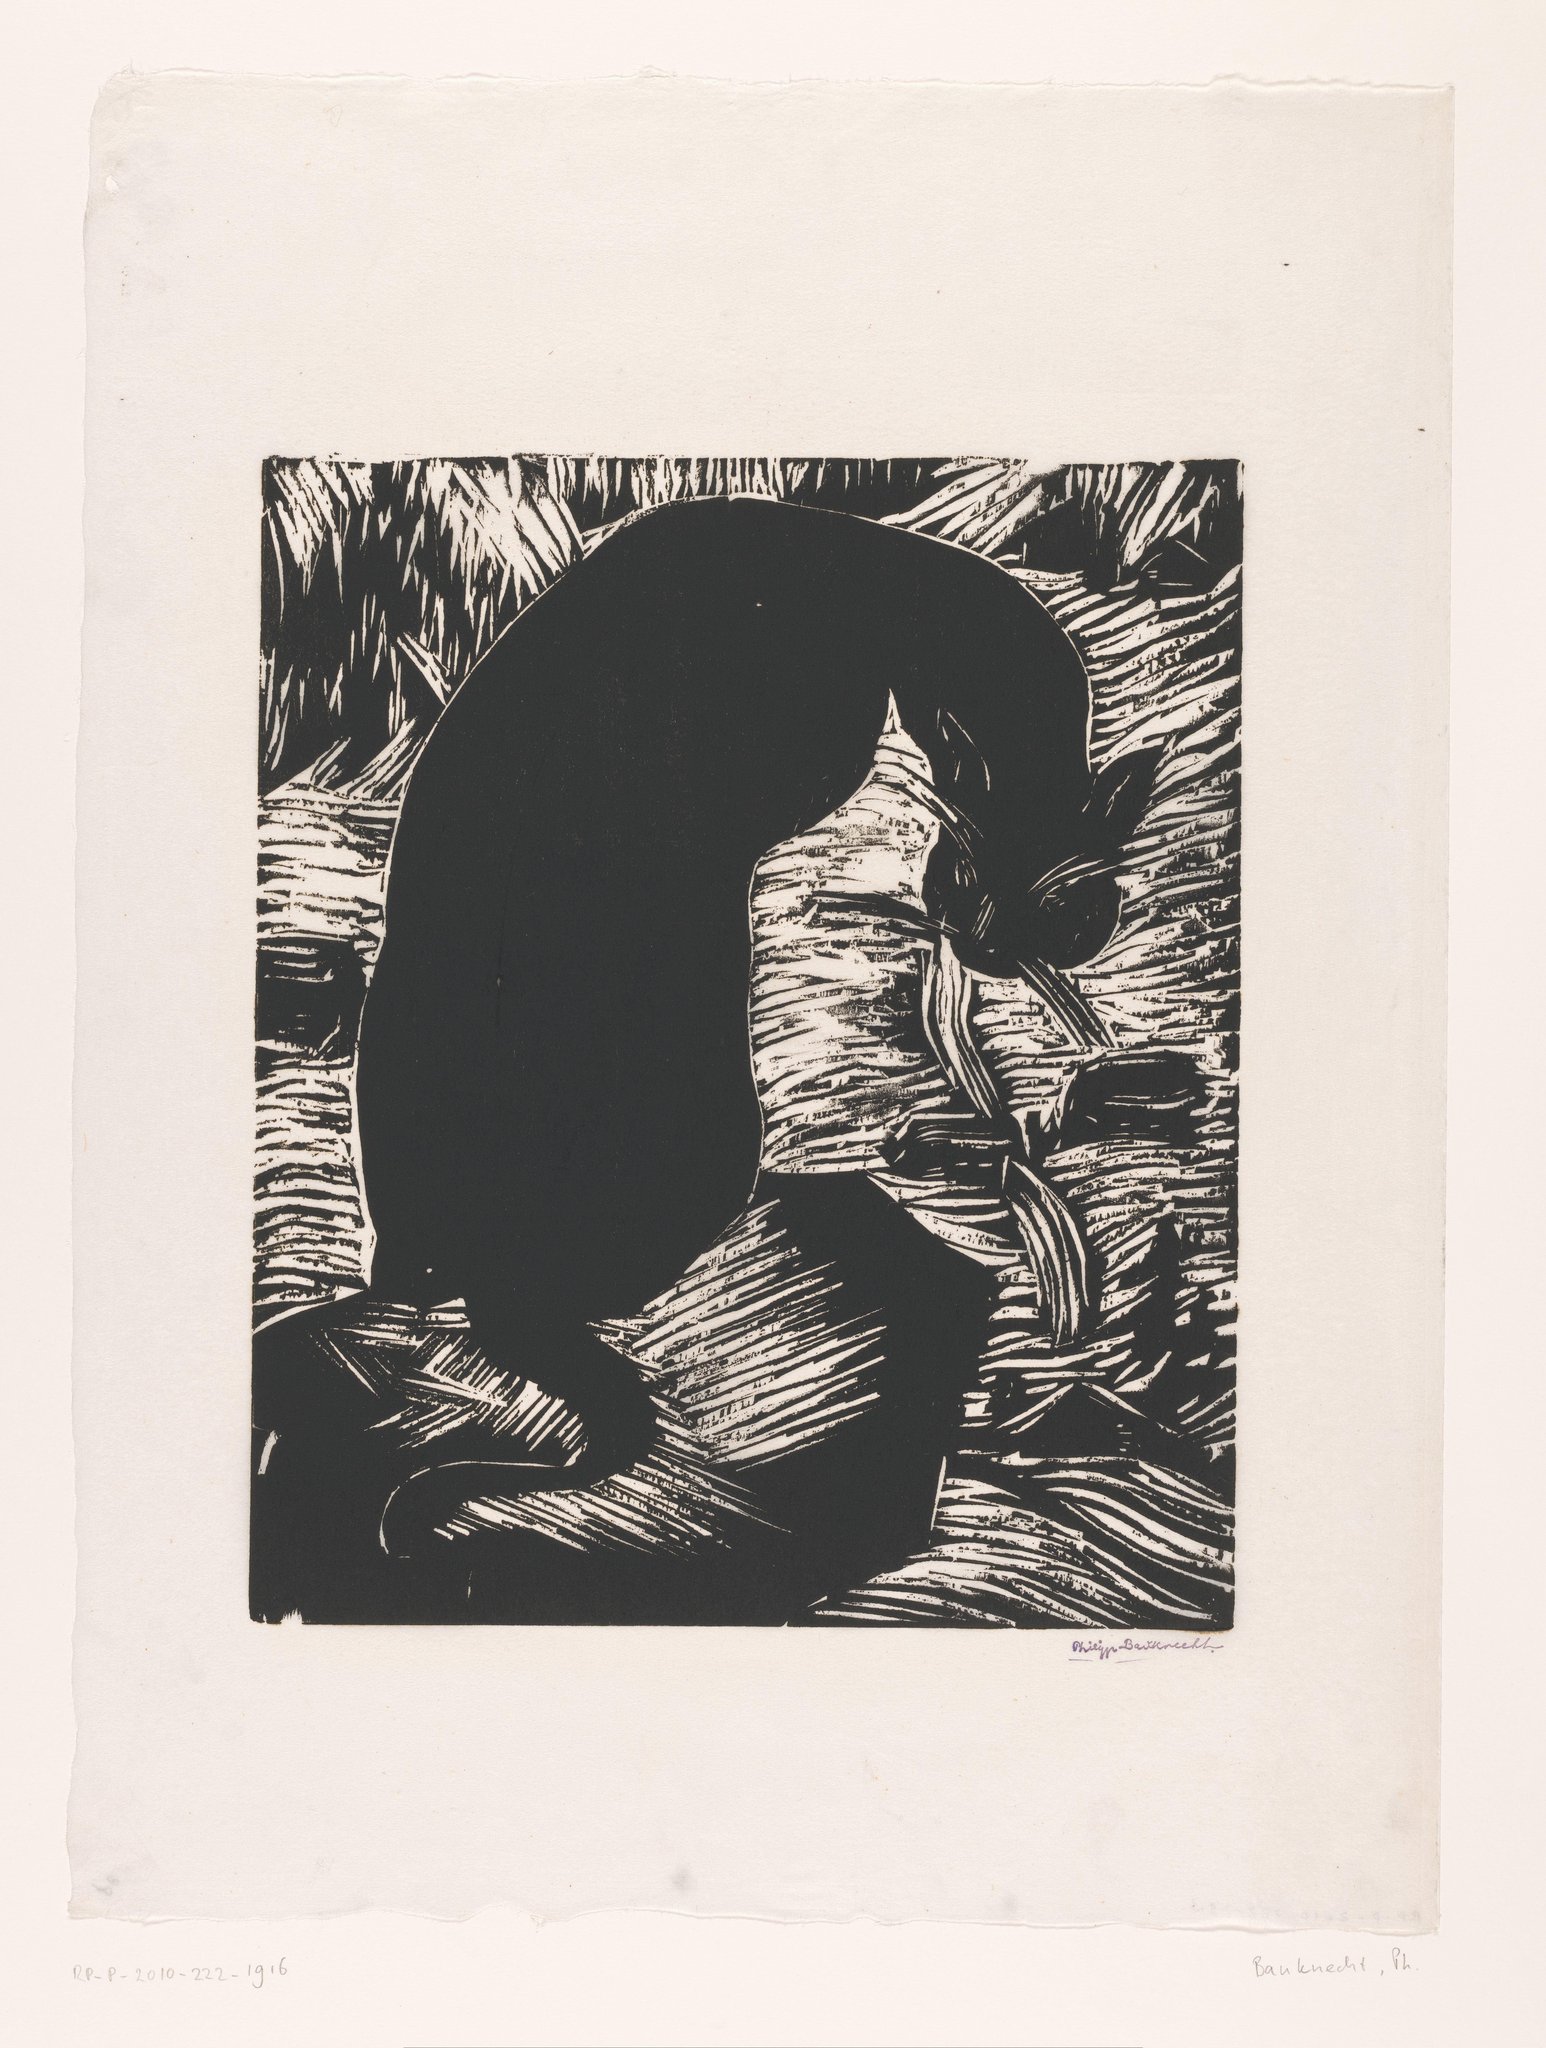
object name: print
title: Over de schouder kijkende zwarte kat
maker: philipp bauknecht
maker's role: print maker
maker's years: 1884-1933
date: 1894-1933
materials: paper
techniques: woodcut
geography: germany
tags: cat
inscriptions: collector's mark: ‘PC’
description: Achterom kijkende zwarte kat met lange hals.